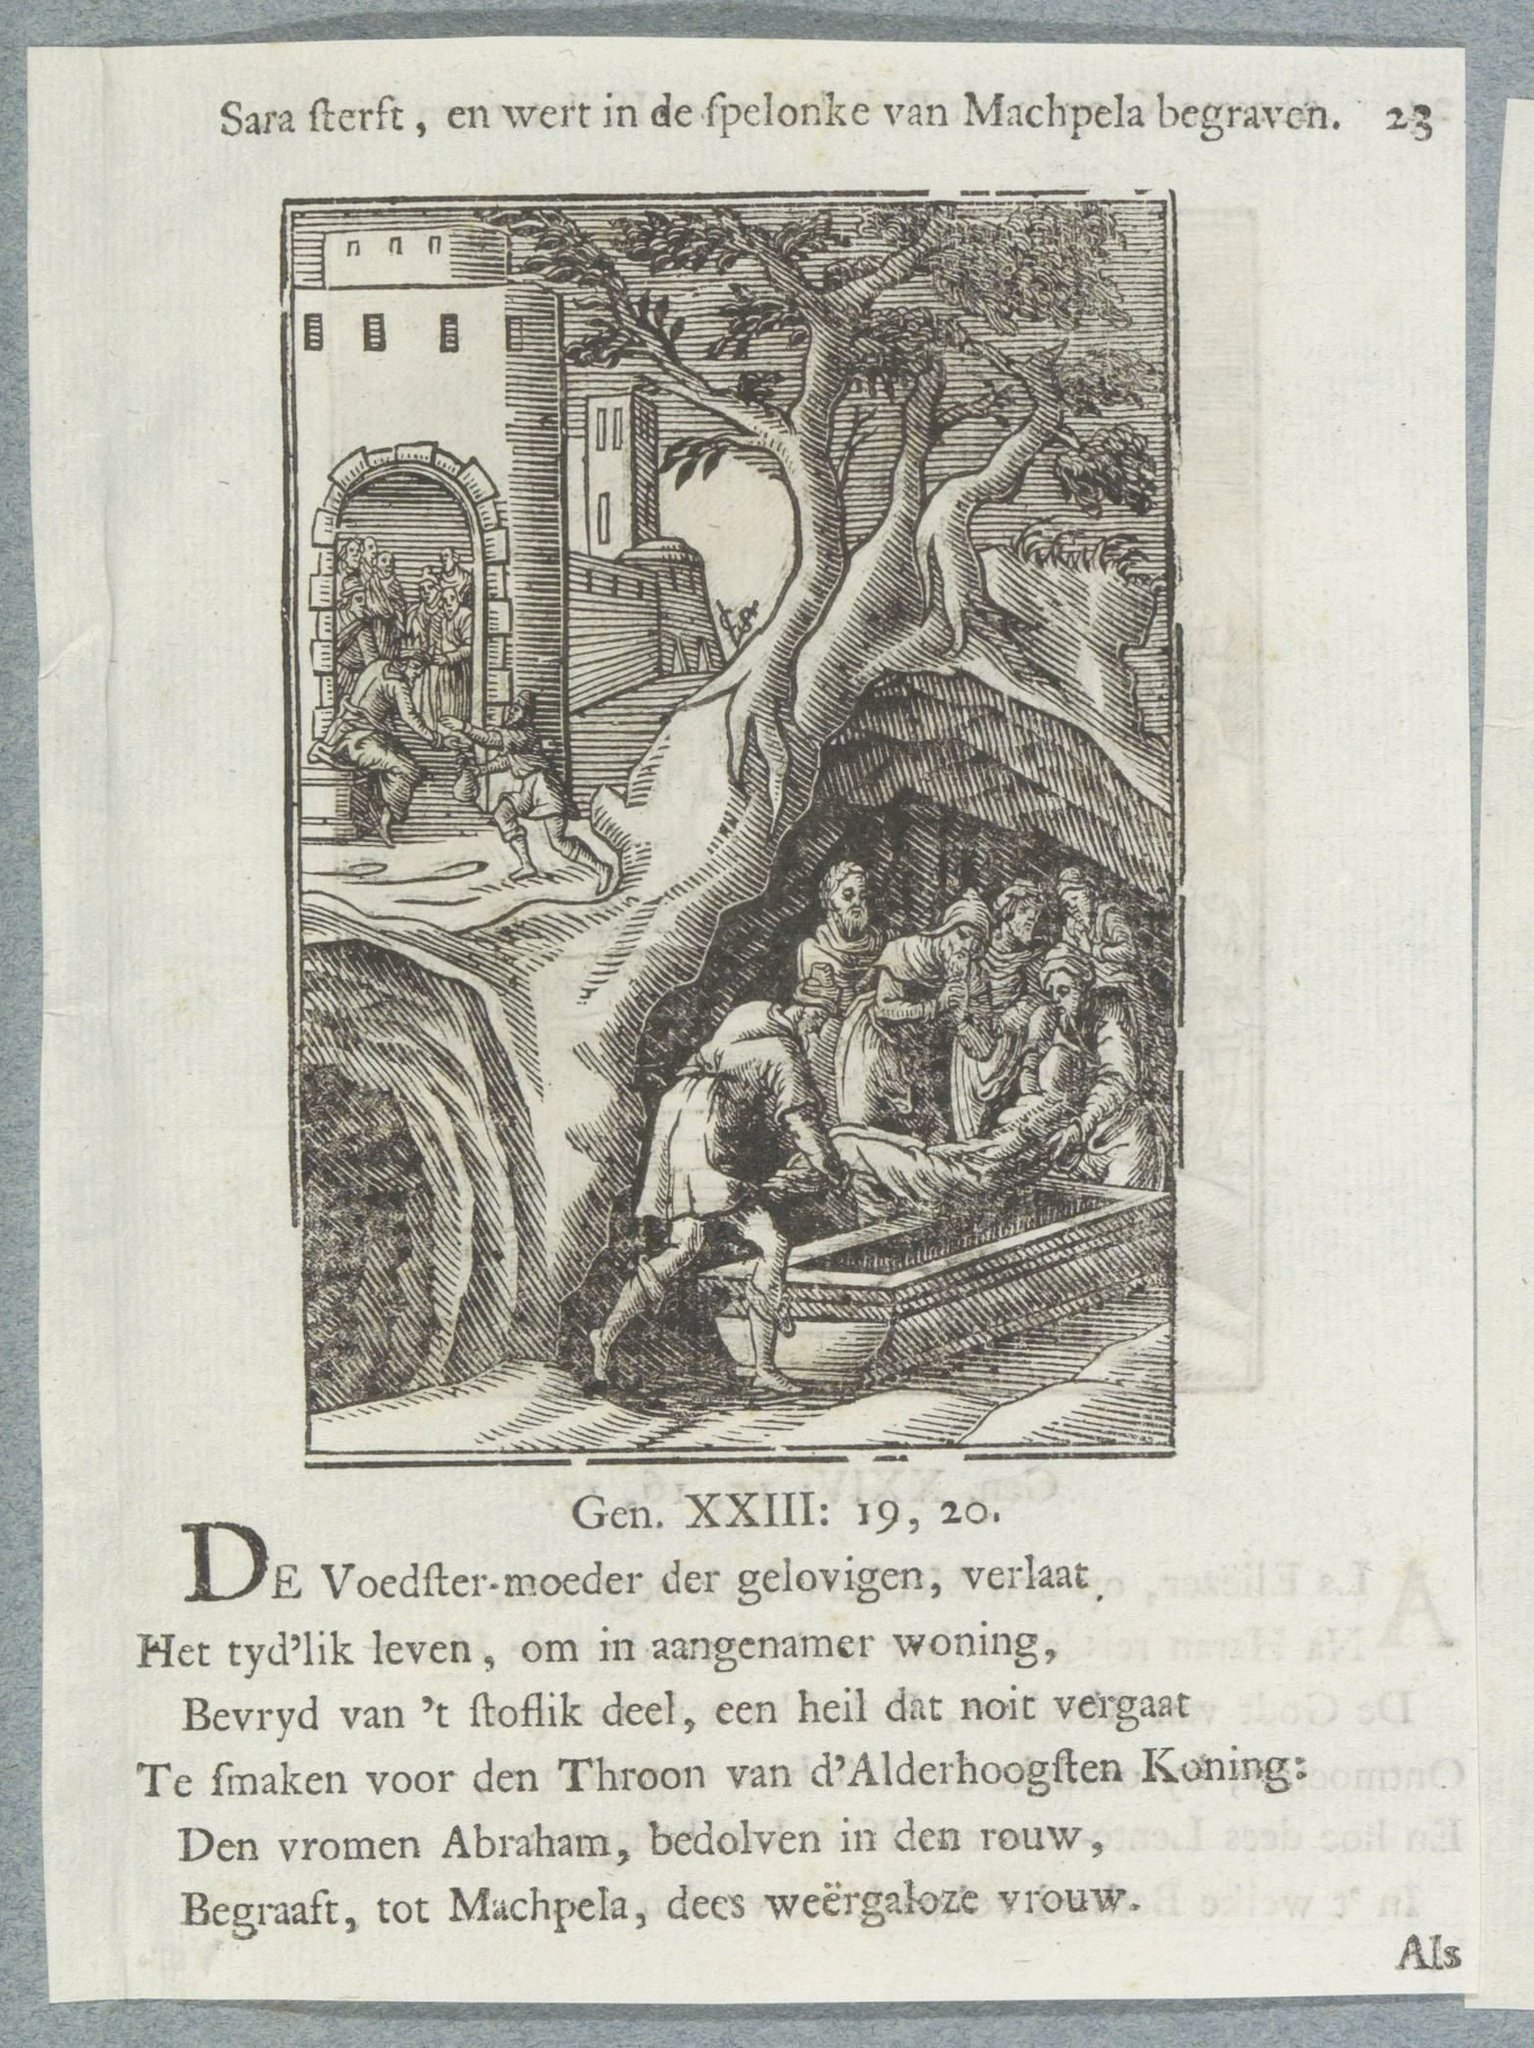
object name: print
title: Sara sterft, en wert in de spelonke van Machpela begraven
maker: jan klooster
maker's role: bookseller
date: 1645-1646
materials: paper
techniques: letterpress printing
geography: amsterdam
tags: abraham weighs out four hundred pieces of silver, sarah's burial in the cave of machpelah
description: De prent is afkomstig uit: Bybels Lusthof. Amsterdam, J. Klooster, 1740. De prent werd gemaakt voor de uitgaven van P.J. Paets uit Amsterdam. Ze komt in ieder geval voor in: Bibels Tresoor ofte der zielen lusthof. Amsterdam, P.J. Paets, 1646. Mogelijk staat ze ook in: Historien ende Prophetien. [Amsterdam], P.J. Paets, 1645.